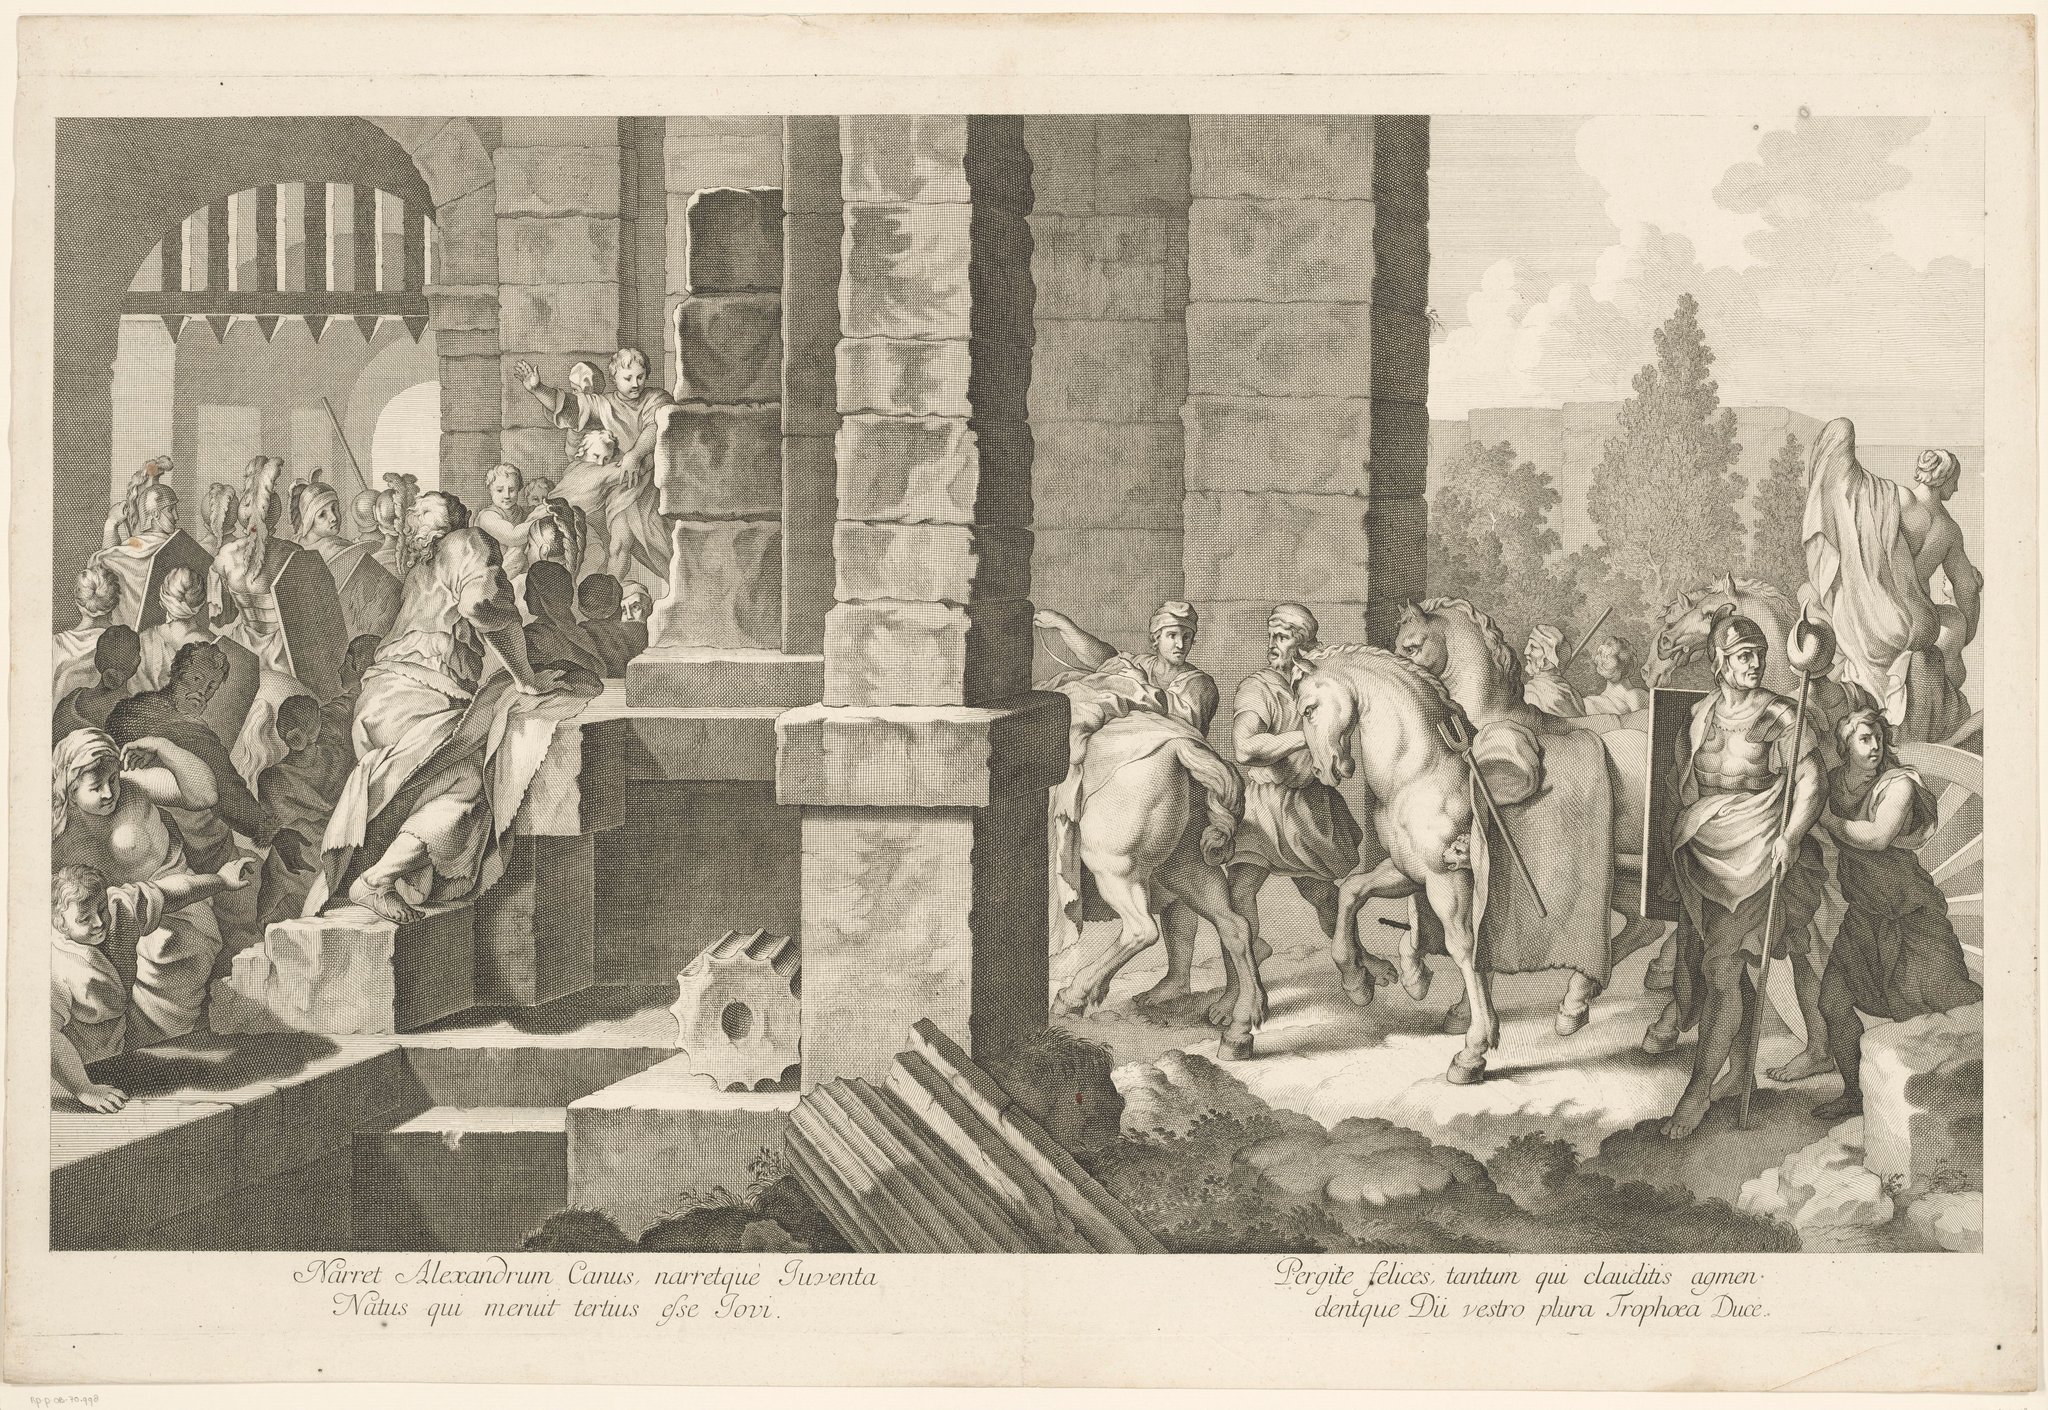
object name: print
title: Militaire stoet entert gebouw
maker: domenico rossetti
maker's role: print maker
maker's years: 1650-1736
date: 1660-1736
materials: paper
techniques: engraving, etching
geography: mannheim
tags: military parade, pageant (+ infantry), the soldier; the soldier's life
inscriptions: collector's mark: Lugt 2228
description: Deze prent maakt deel uit van een reeks van twaalf prenten door verschillende prentmakers naar de grisailles door Gerard de Lairesse in Schloss Mannheim van de Triomftocht van Alexander de Grote in Babylon.